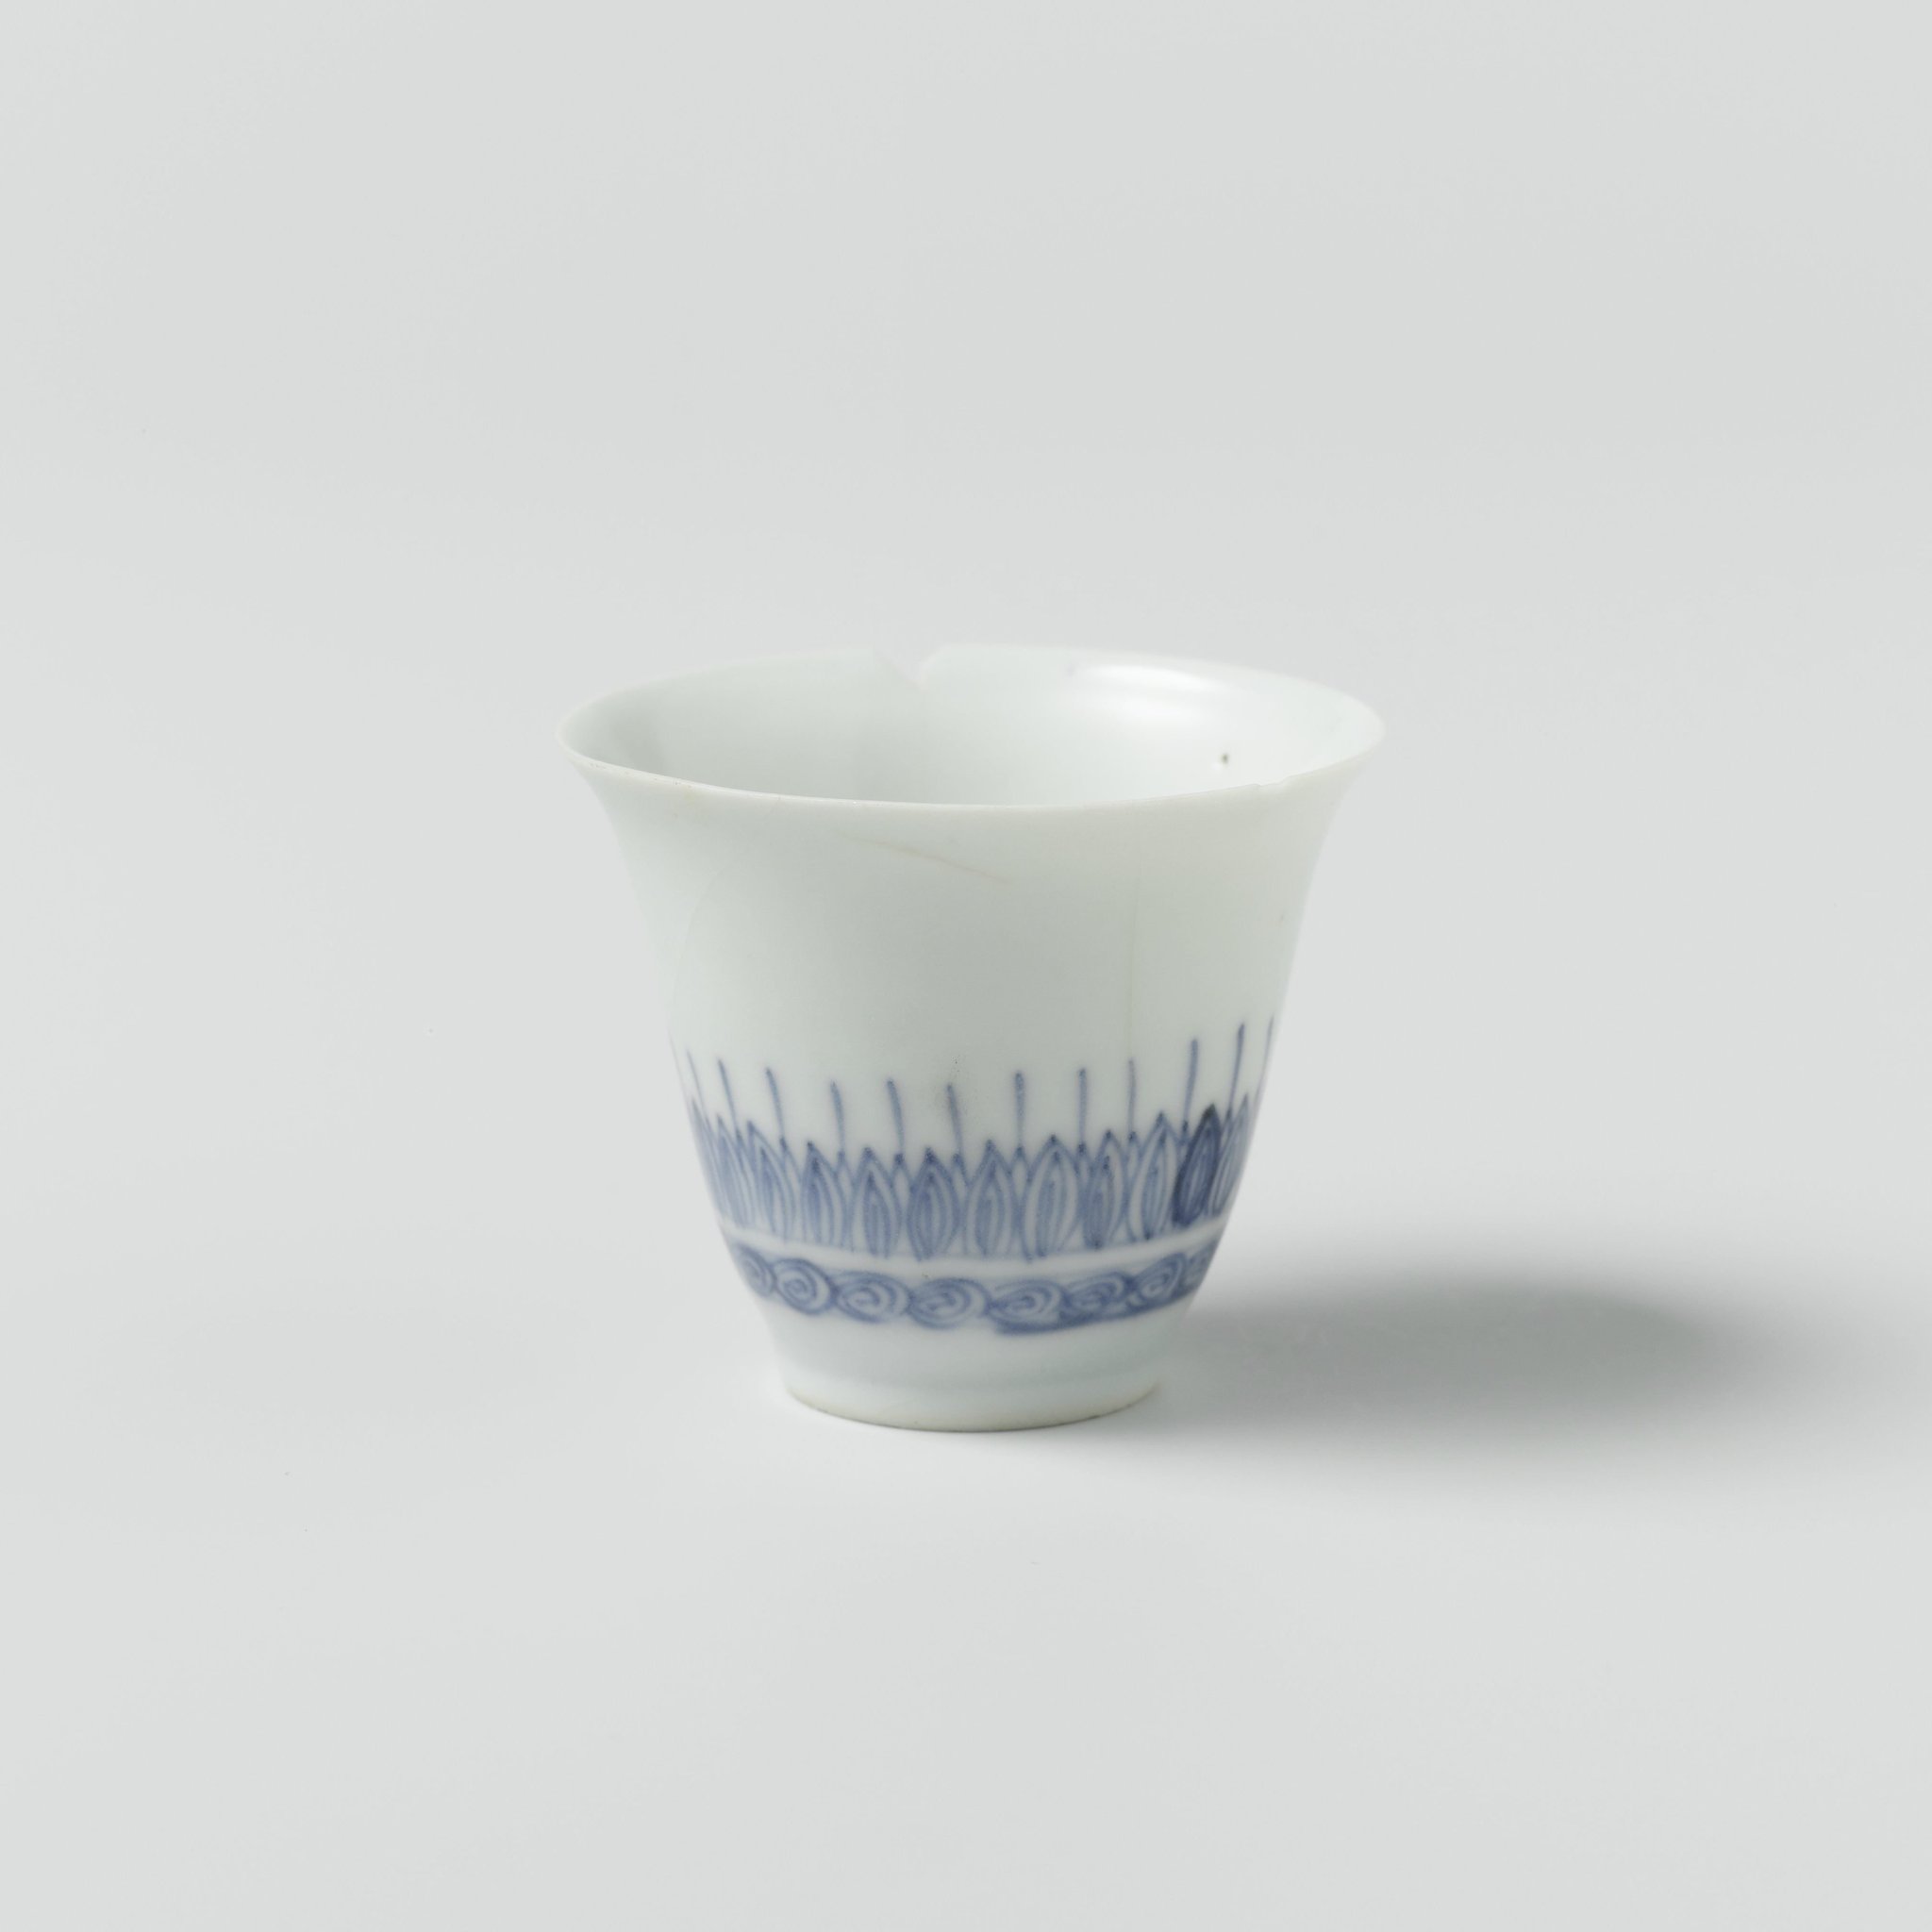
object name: cup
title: Wijnkop uit V.O.C.-schip de 'Witte Leeuw'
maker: Anonymous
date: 1613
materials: porcelain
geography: jingdezhen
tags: verenigde oostindische compagnie, sint-helena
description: Wijnkop uit V.O.C.-schip de 'Witte Leeuw', circa 99% bewaard. De scherf is glasachtig en wit. Het glazuur is blauw getint en mat en vertoont pinholes en kleine bakscheurtjes op de bodem. De bodem is geglazuurd en loopt op bij de voetring die recht en gefacetteerd is en naar binnen staat. Er is geen ovenzand aangetroffen.